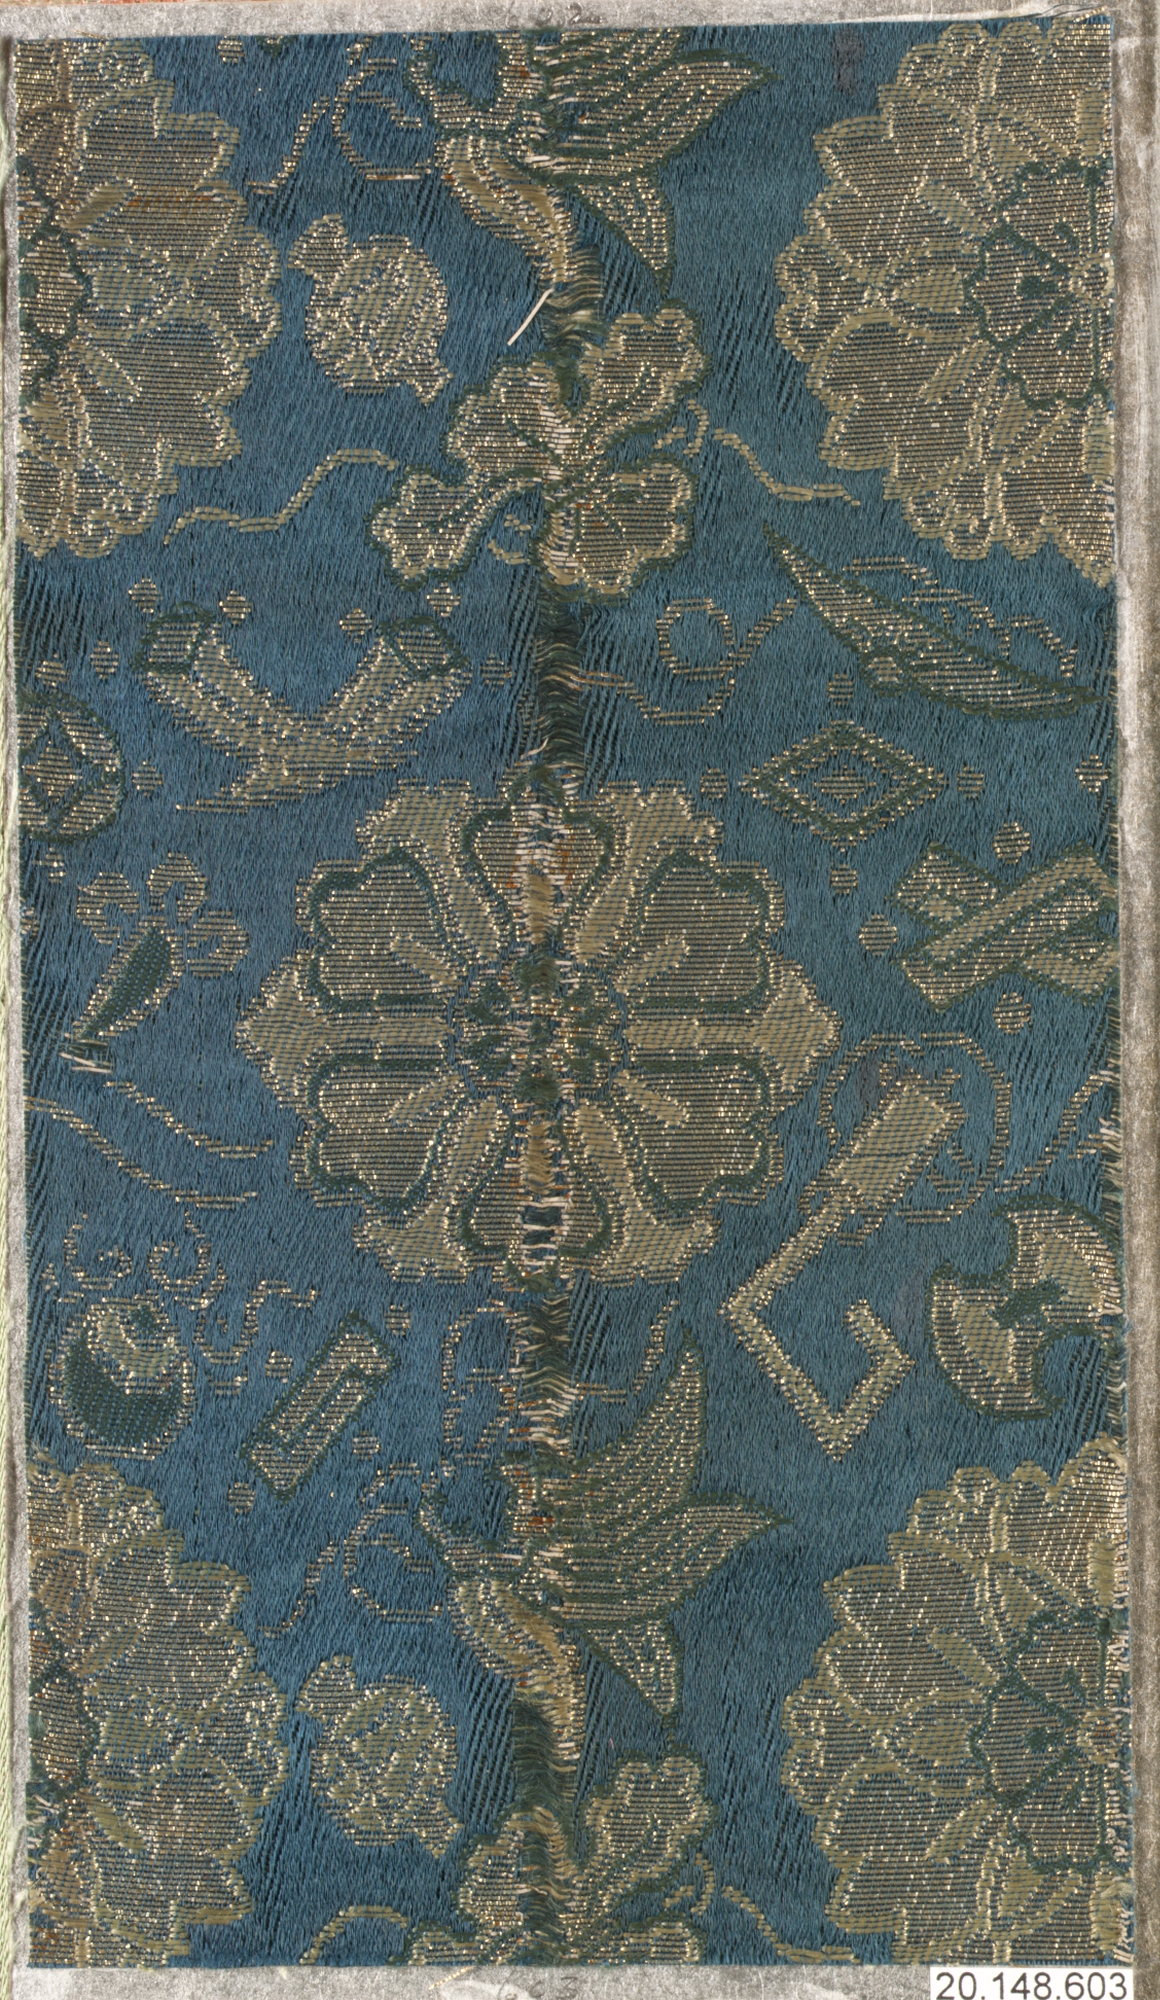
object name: piece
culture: japanese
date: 1601-1700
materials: silk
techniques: compound weave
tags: flowers,leaves